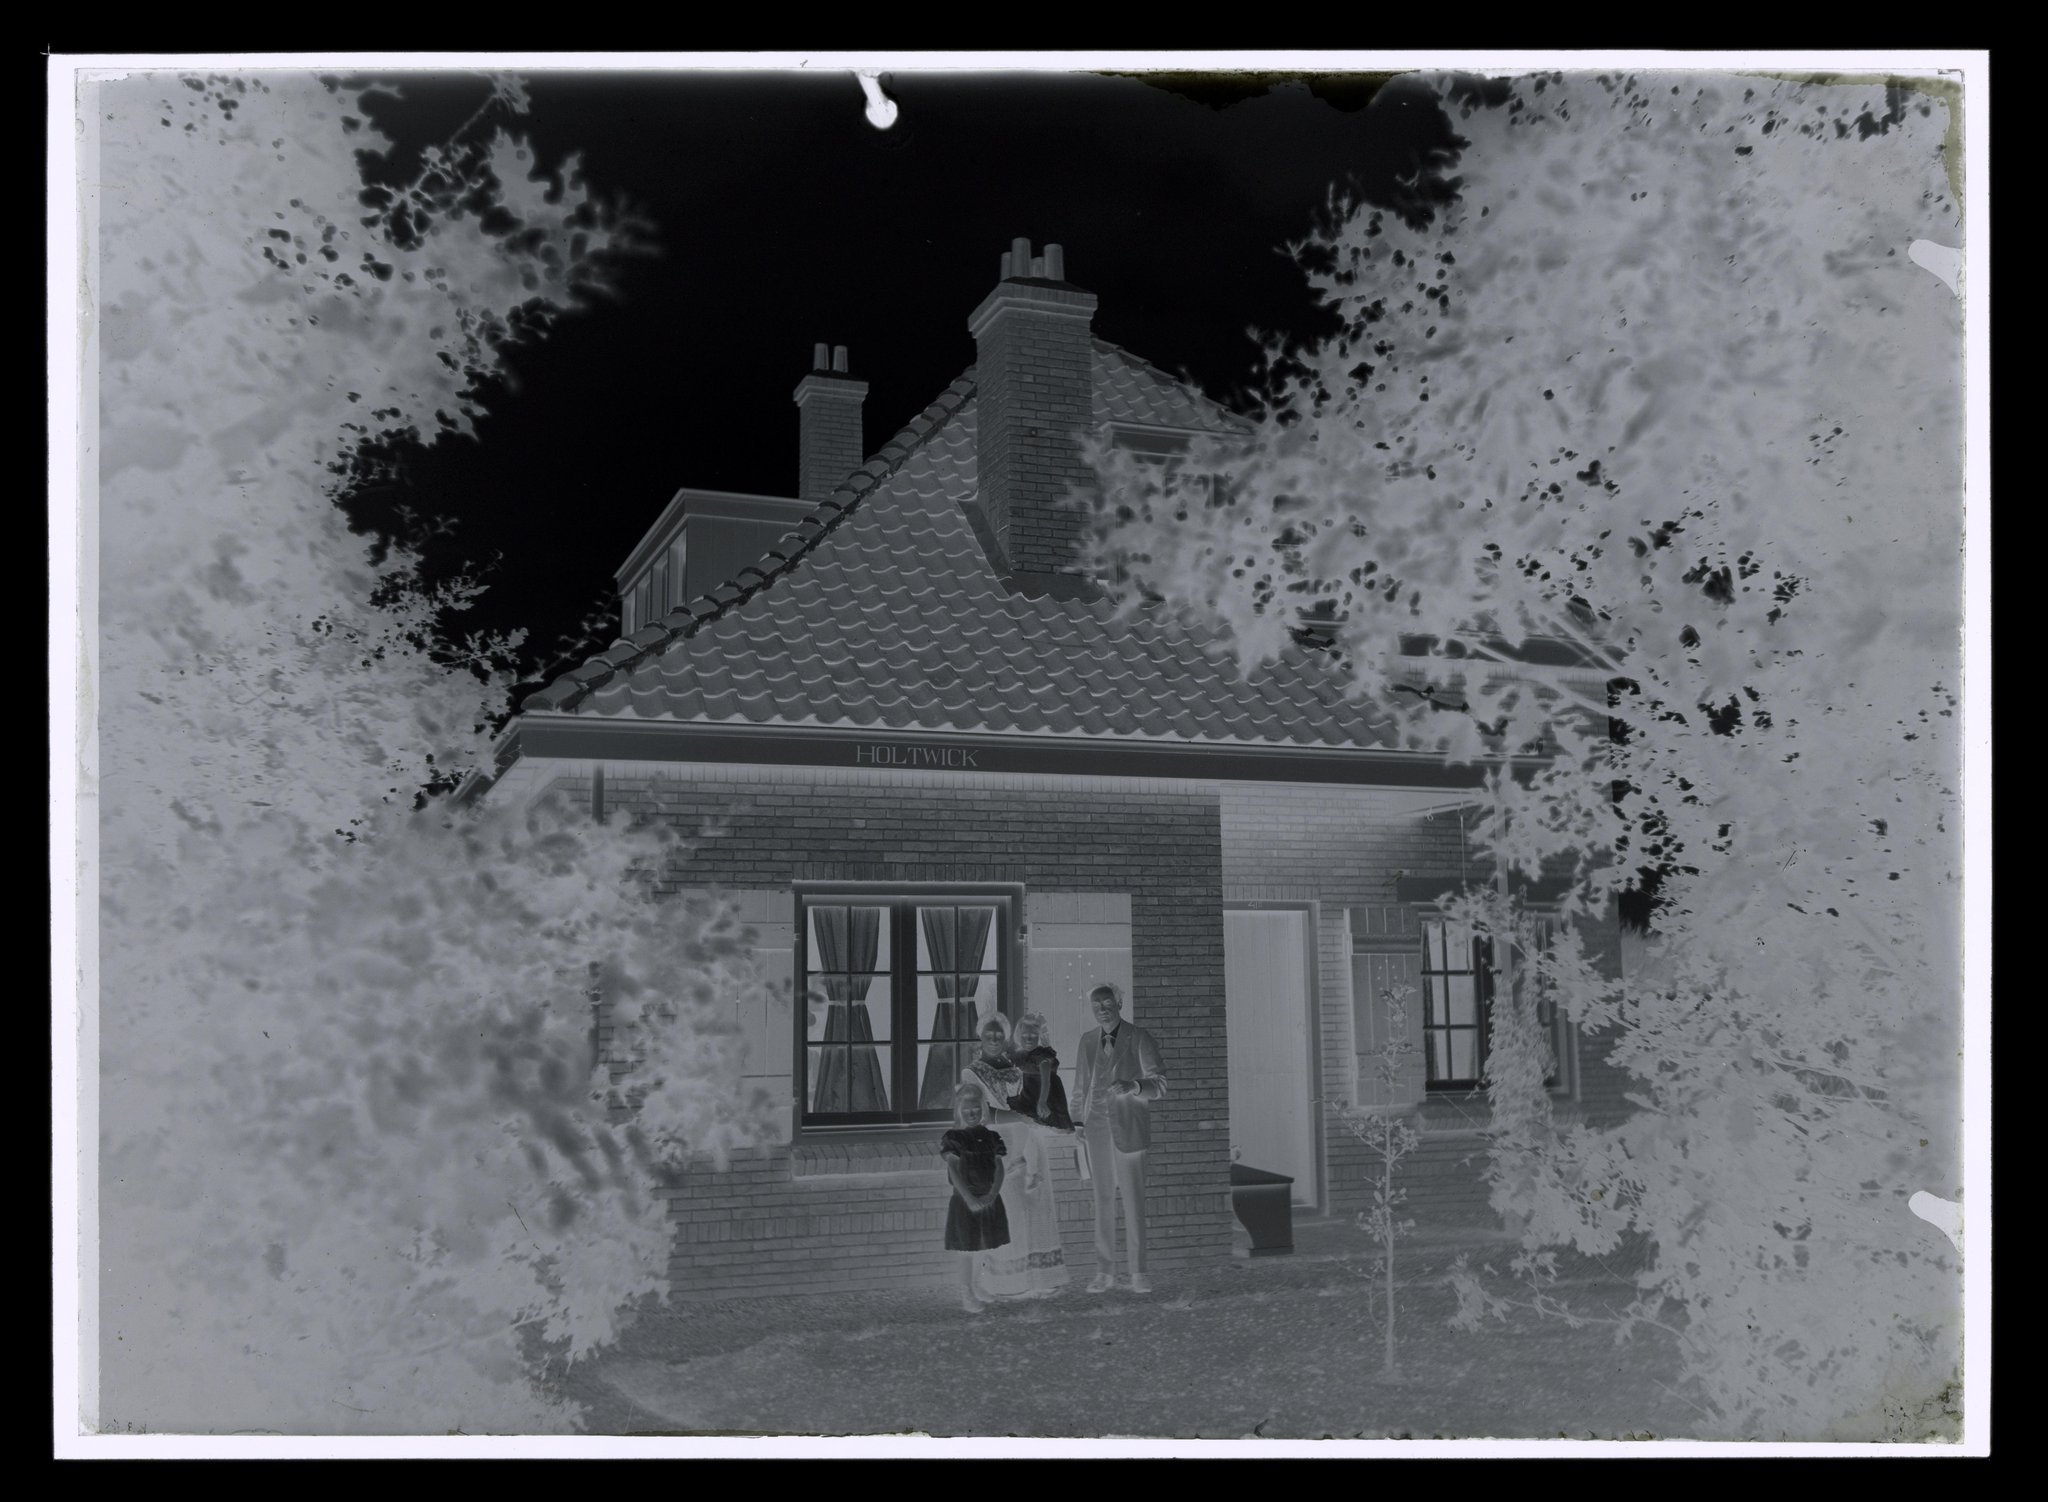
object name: glasnegatief, glasplaatnegatief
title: Elsa en Alphons Diepenbrock met kinderen Joanna en Thea voor hun woning 'Holtwick' te Laren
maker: wouterus gijsbertus hondius van den broek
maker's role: amateurfotograaf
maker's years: 1867-1913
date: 1911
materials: glass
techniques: gelatin glass negative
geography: laren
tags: elsa diepenbrock, amsterdam, alphons diepenbrock, family group, especially parents with their child(ren), façade (of house or building)